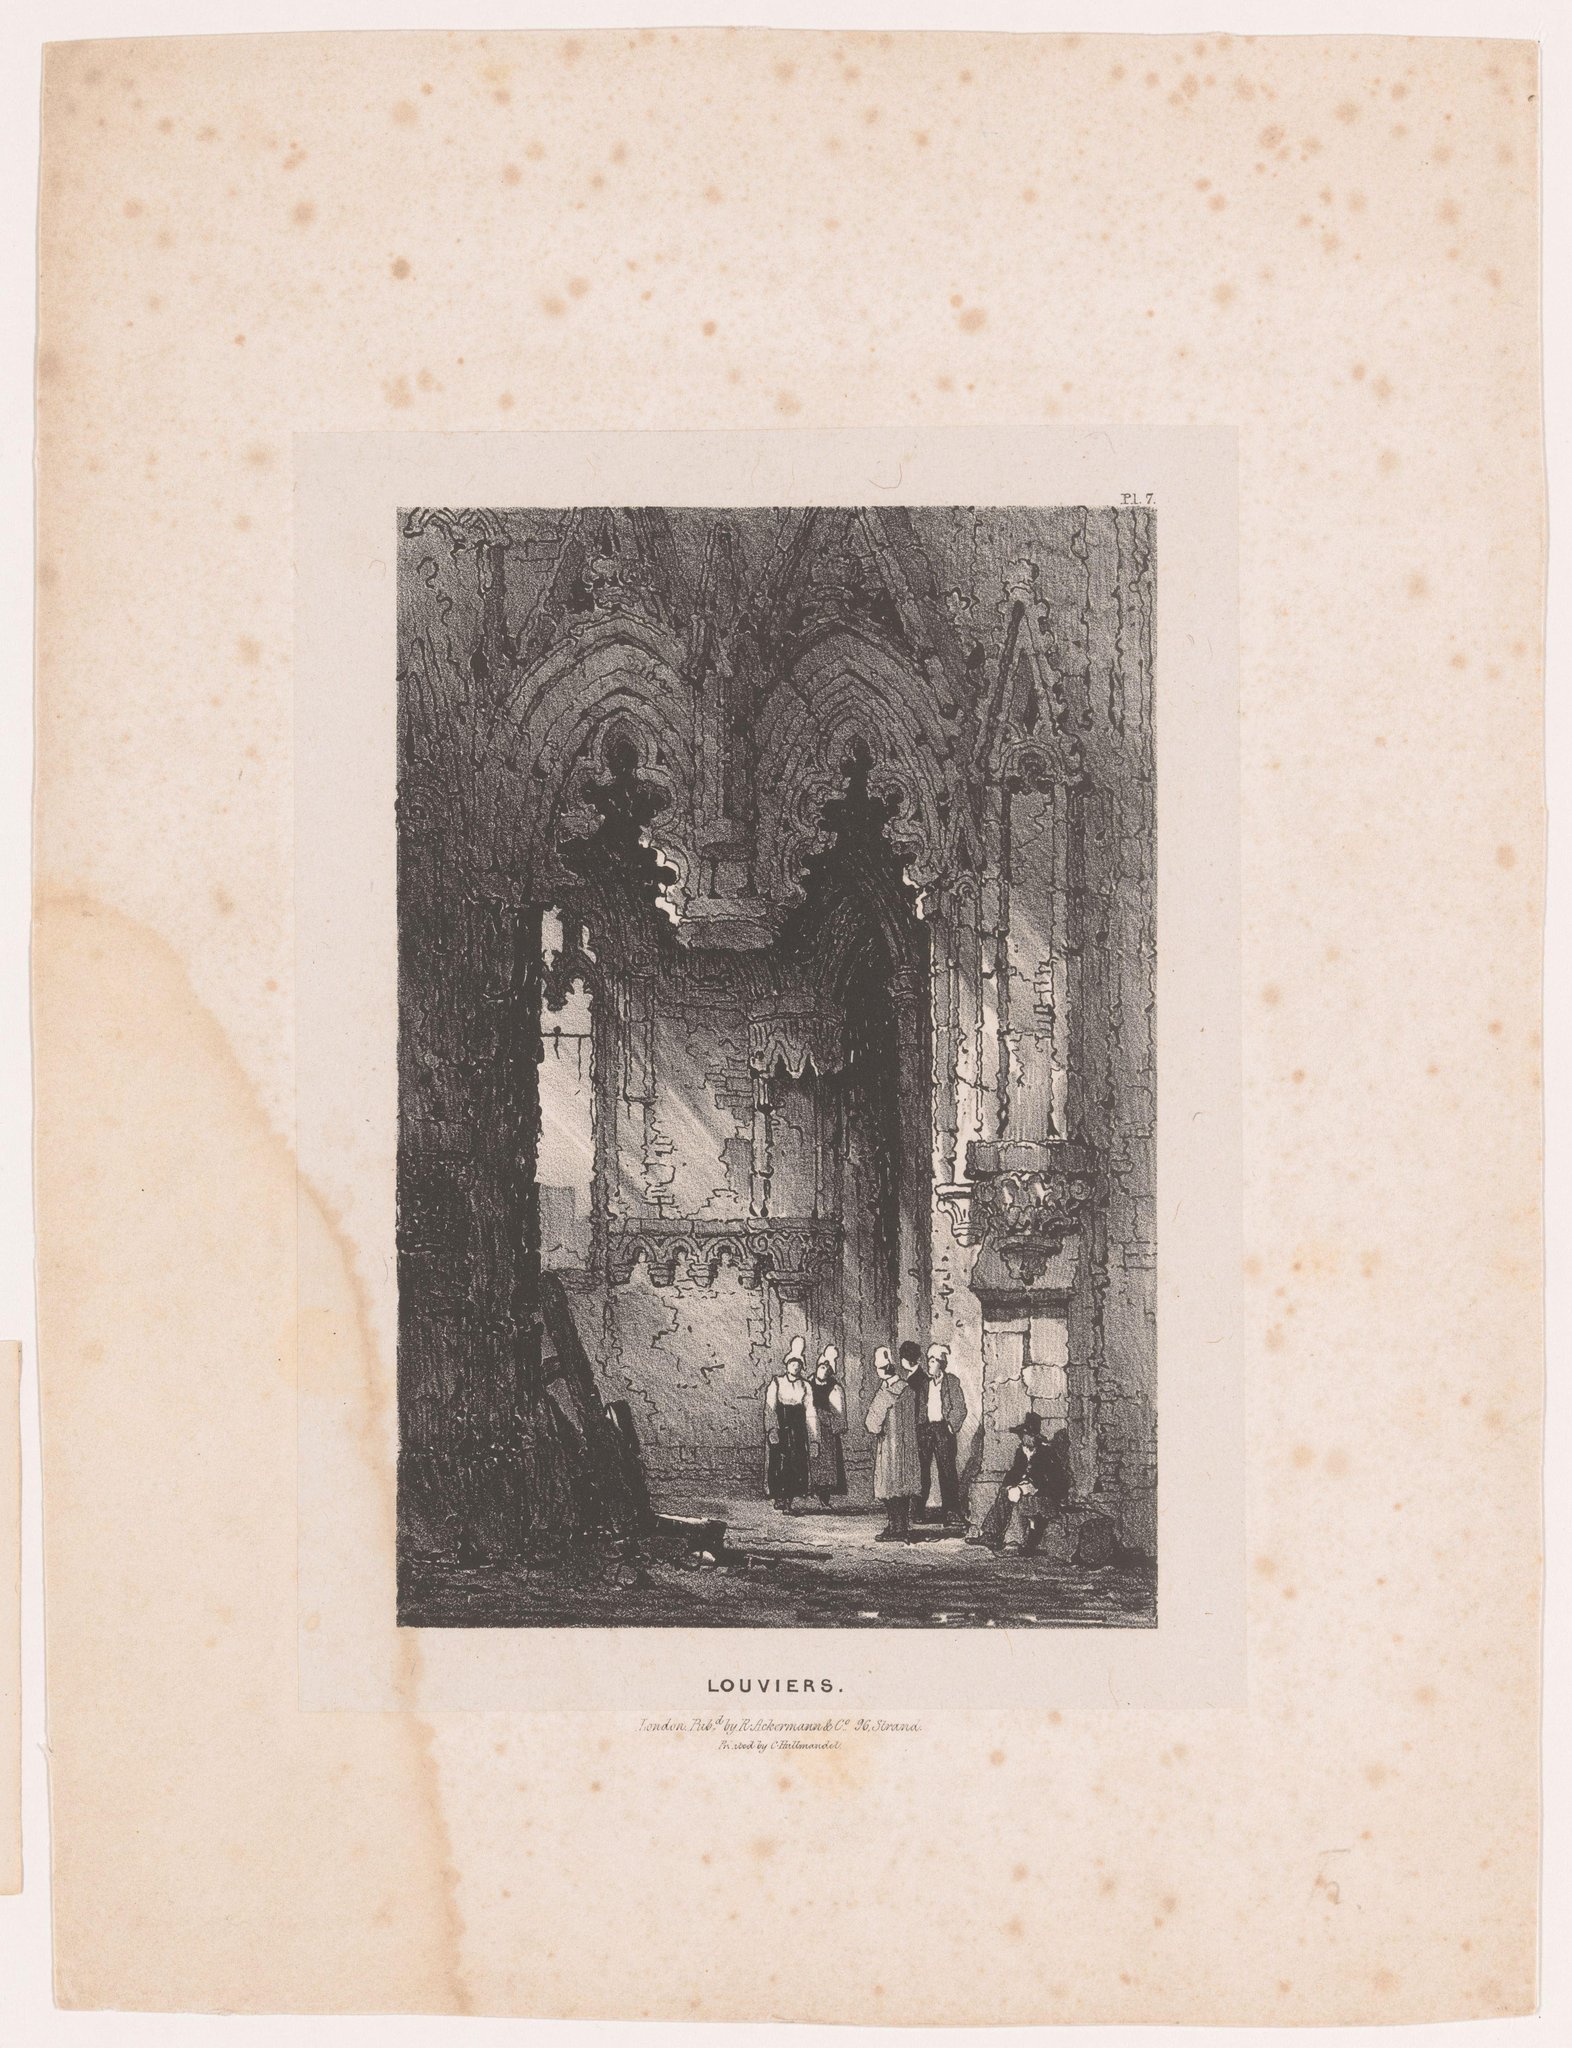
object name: print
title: Interieurs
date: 1832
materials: paper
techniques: lithograph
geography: london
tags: roman catholic church, interior of church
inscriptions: collector's mark: Lugt 2228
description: Rechtsboven genummerd; pl. 7. Onderdeel van een serie.